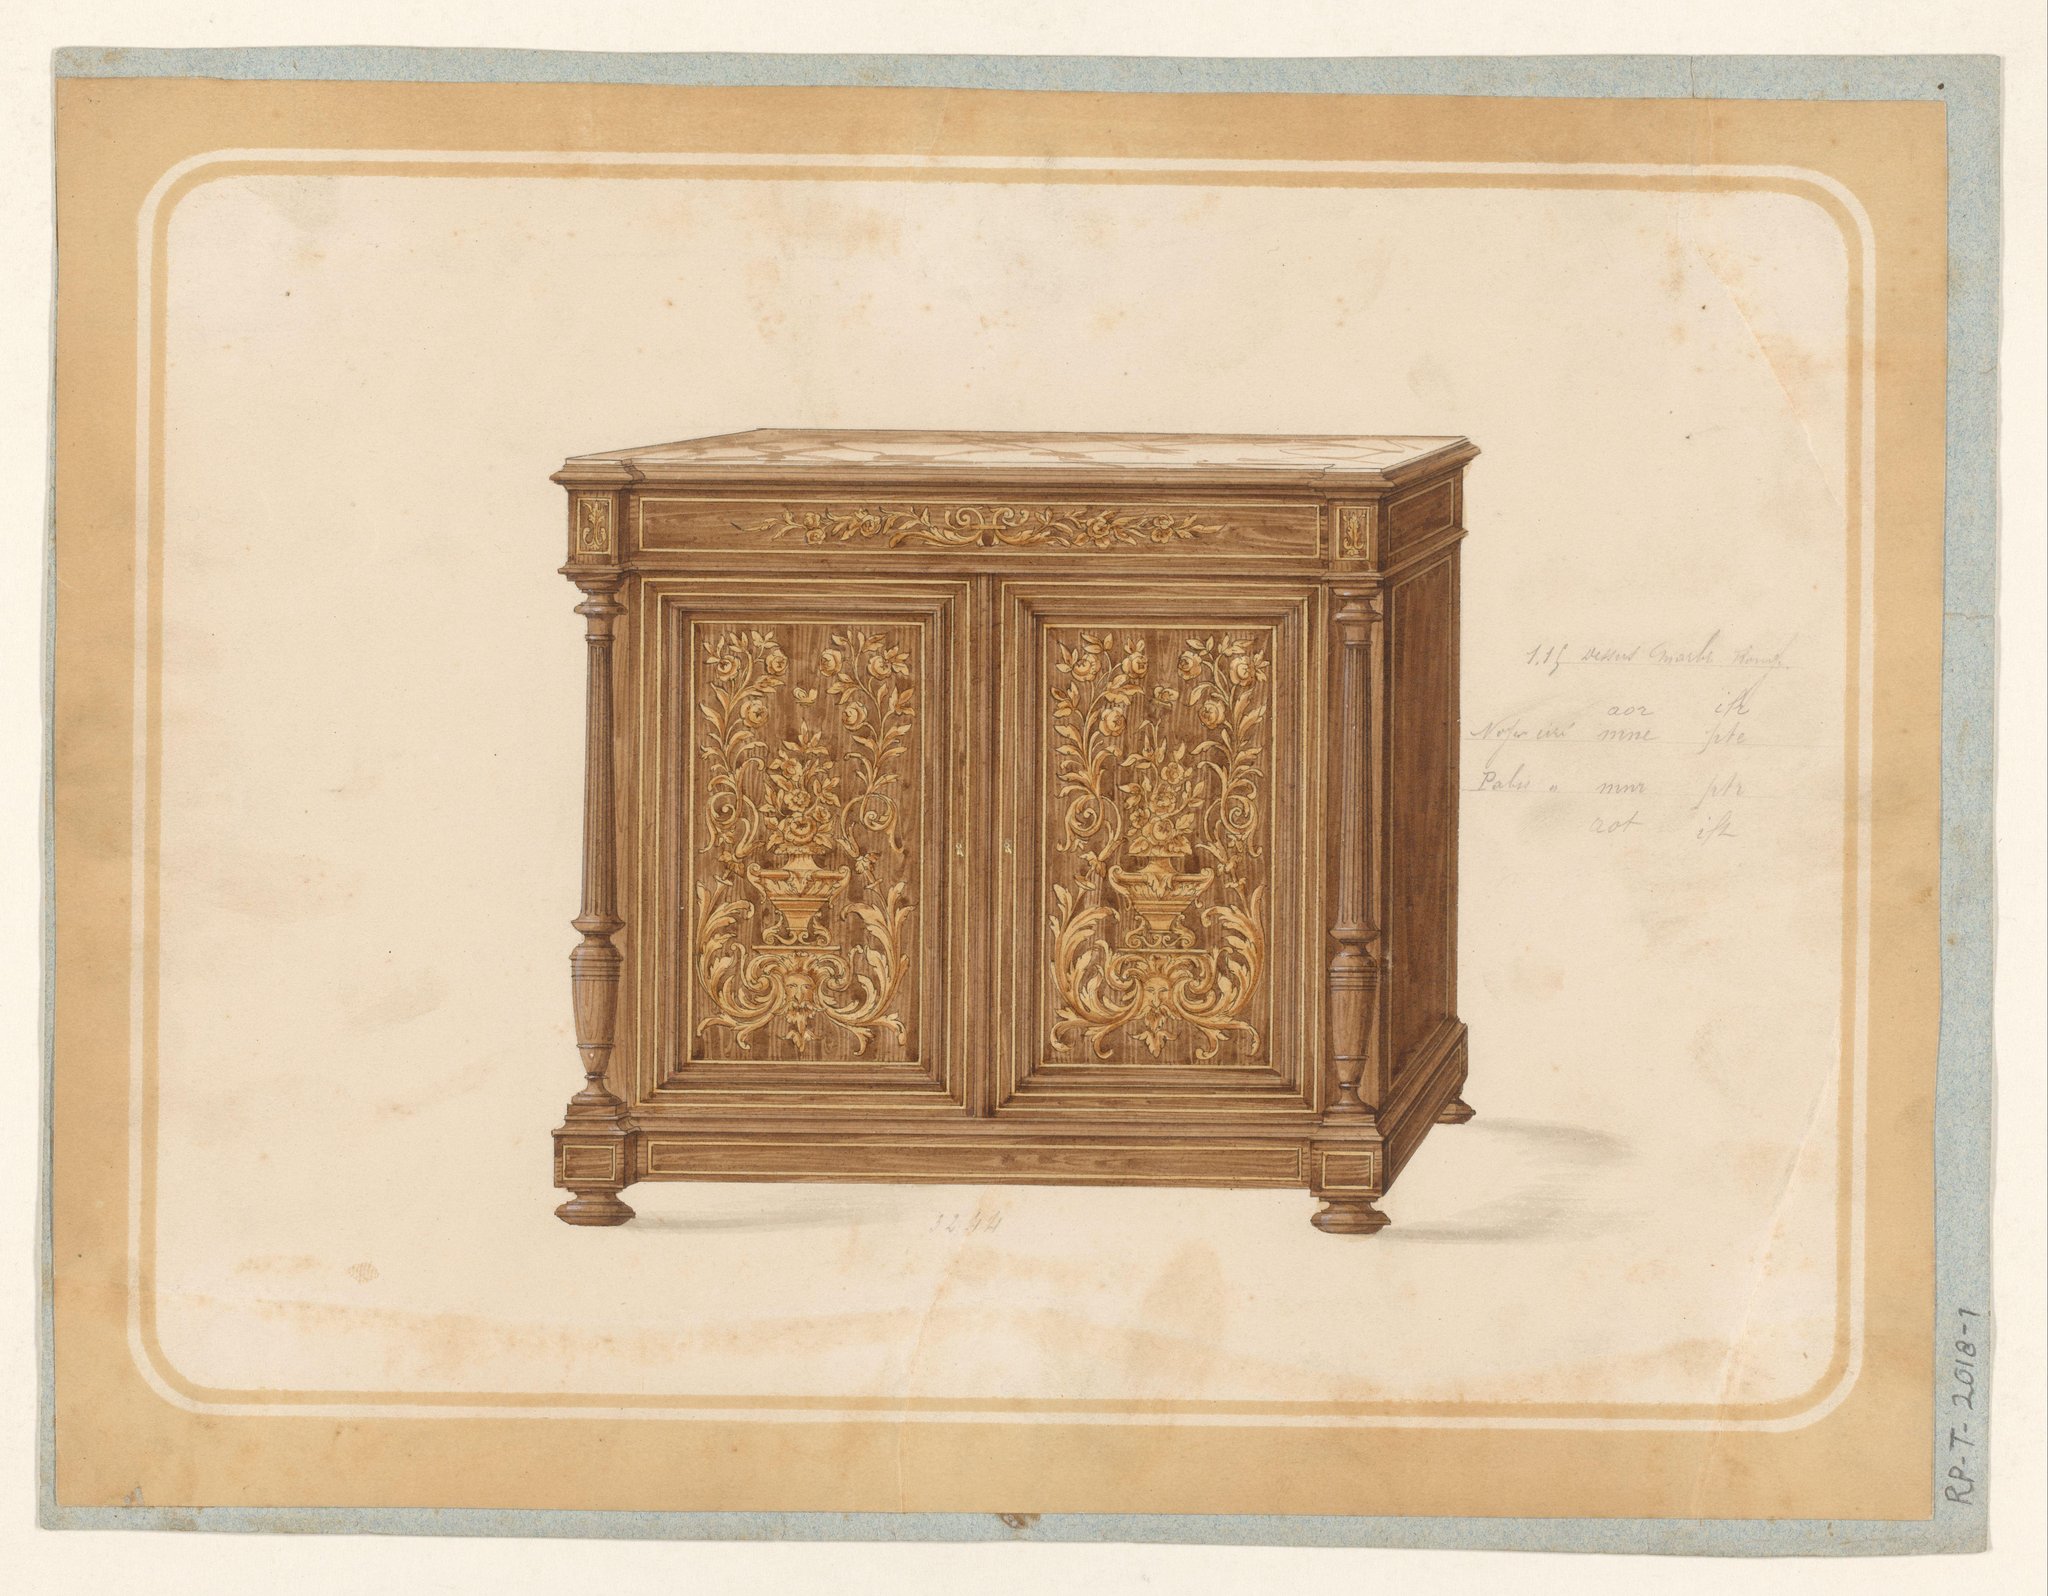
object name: drawing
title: Kast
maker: Anonymous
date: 1835-1935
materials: ink, paper, watercolor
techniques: drawing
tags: ornamental cupboard, decorative furniture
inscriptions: annotation: ‘1.15 [...] marbre [...]’, number: ‘3244’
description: De tekening is op een blad geplakt. Op de andere zijde van dit blad is RP-T-2018-2 geplakt.